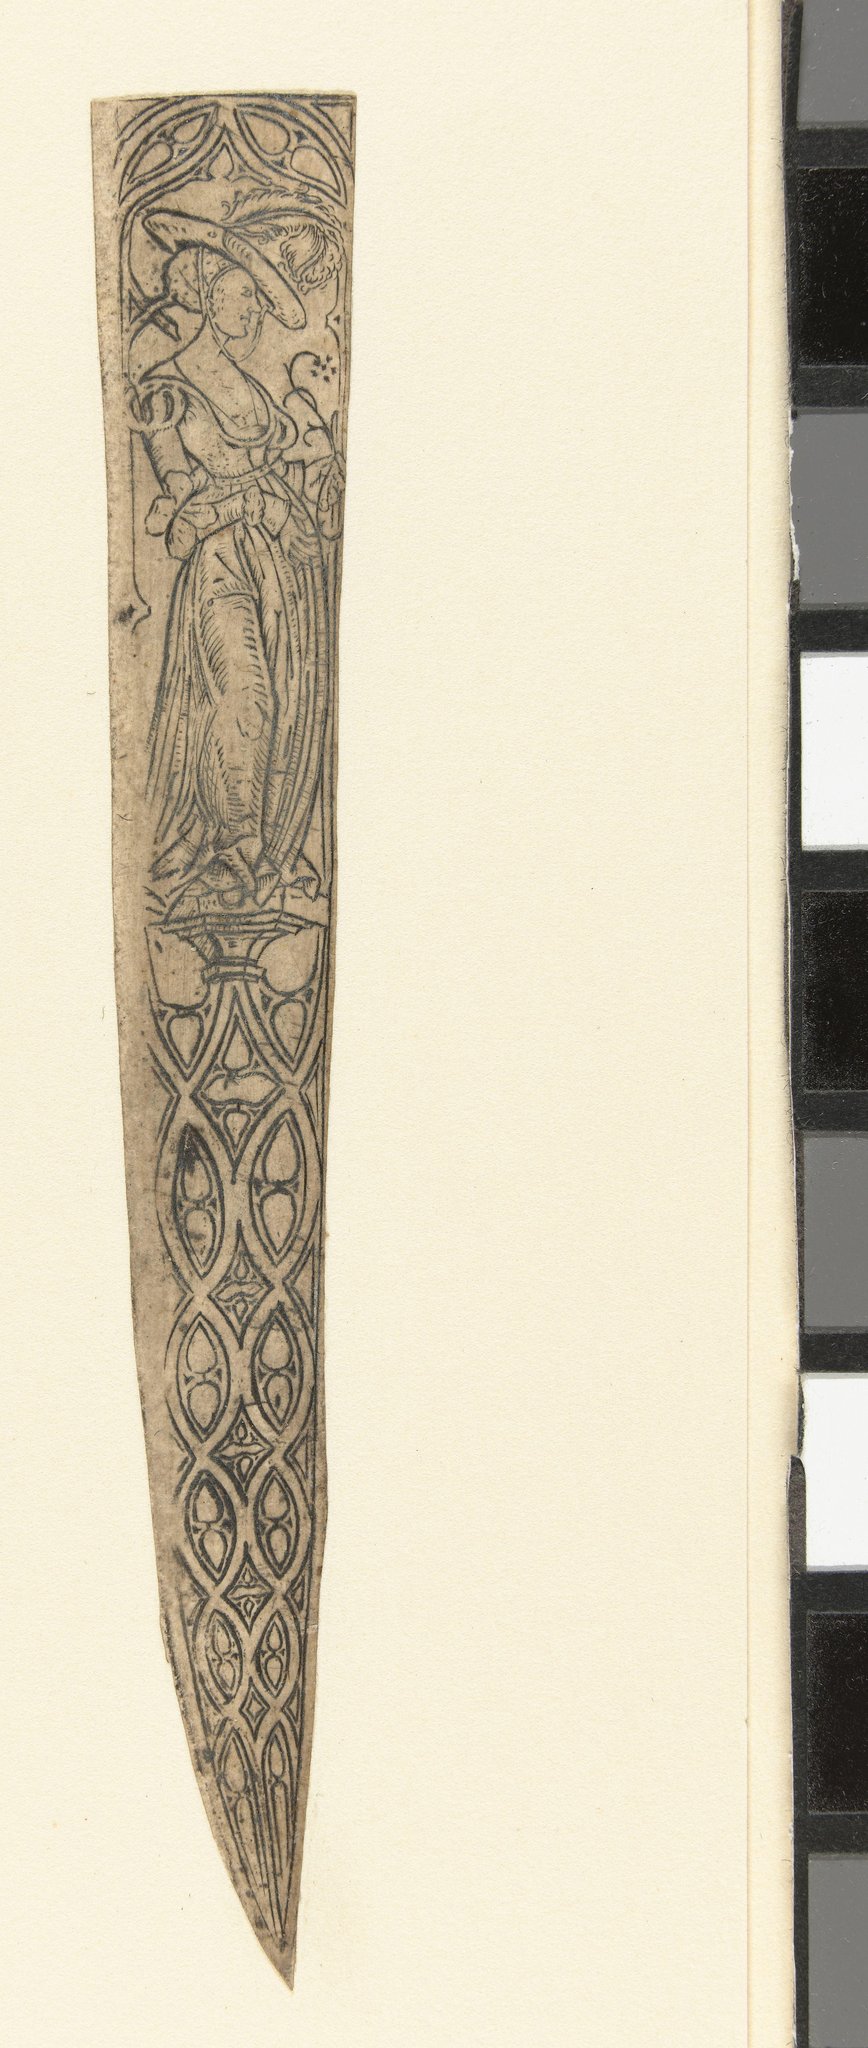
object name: print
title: Scheden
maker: Anonymous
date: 1500-1600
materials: paper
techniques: engraving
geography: germany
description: Bovenaan staat een vrouw met een hoed op en een bloem in haar hand onder een spitsboog. Het onderste gedeelte is gedecoreerd met geometrische motieven.